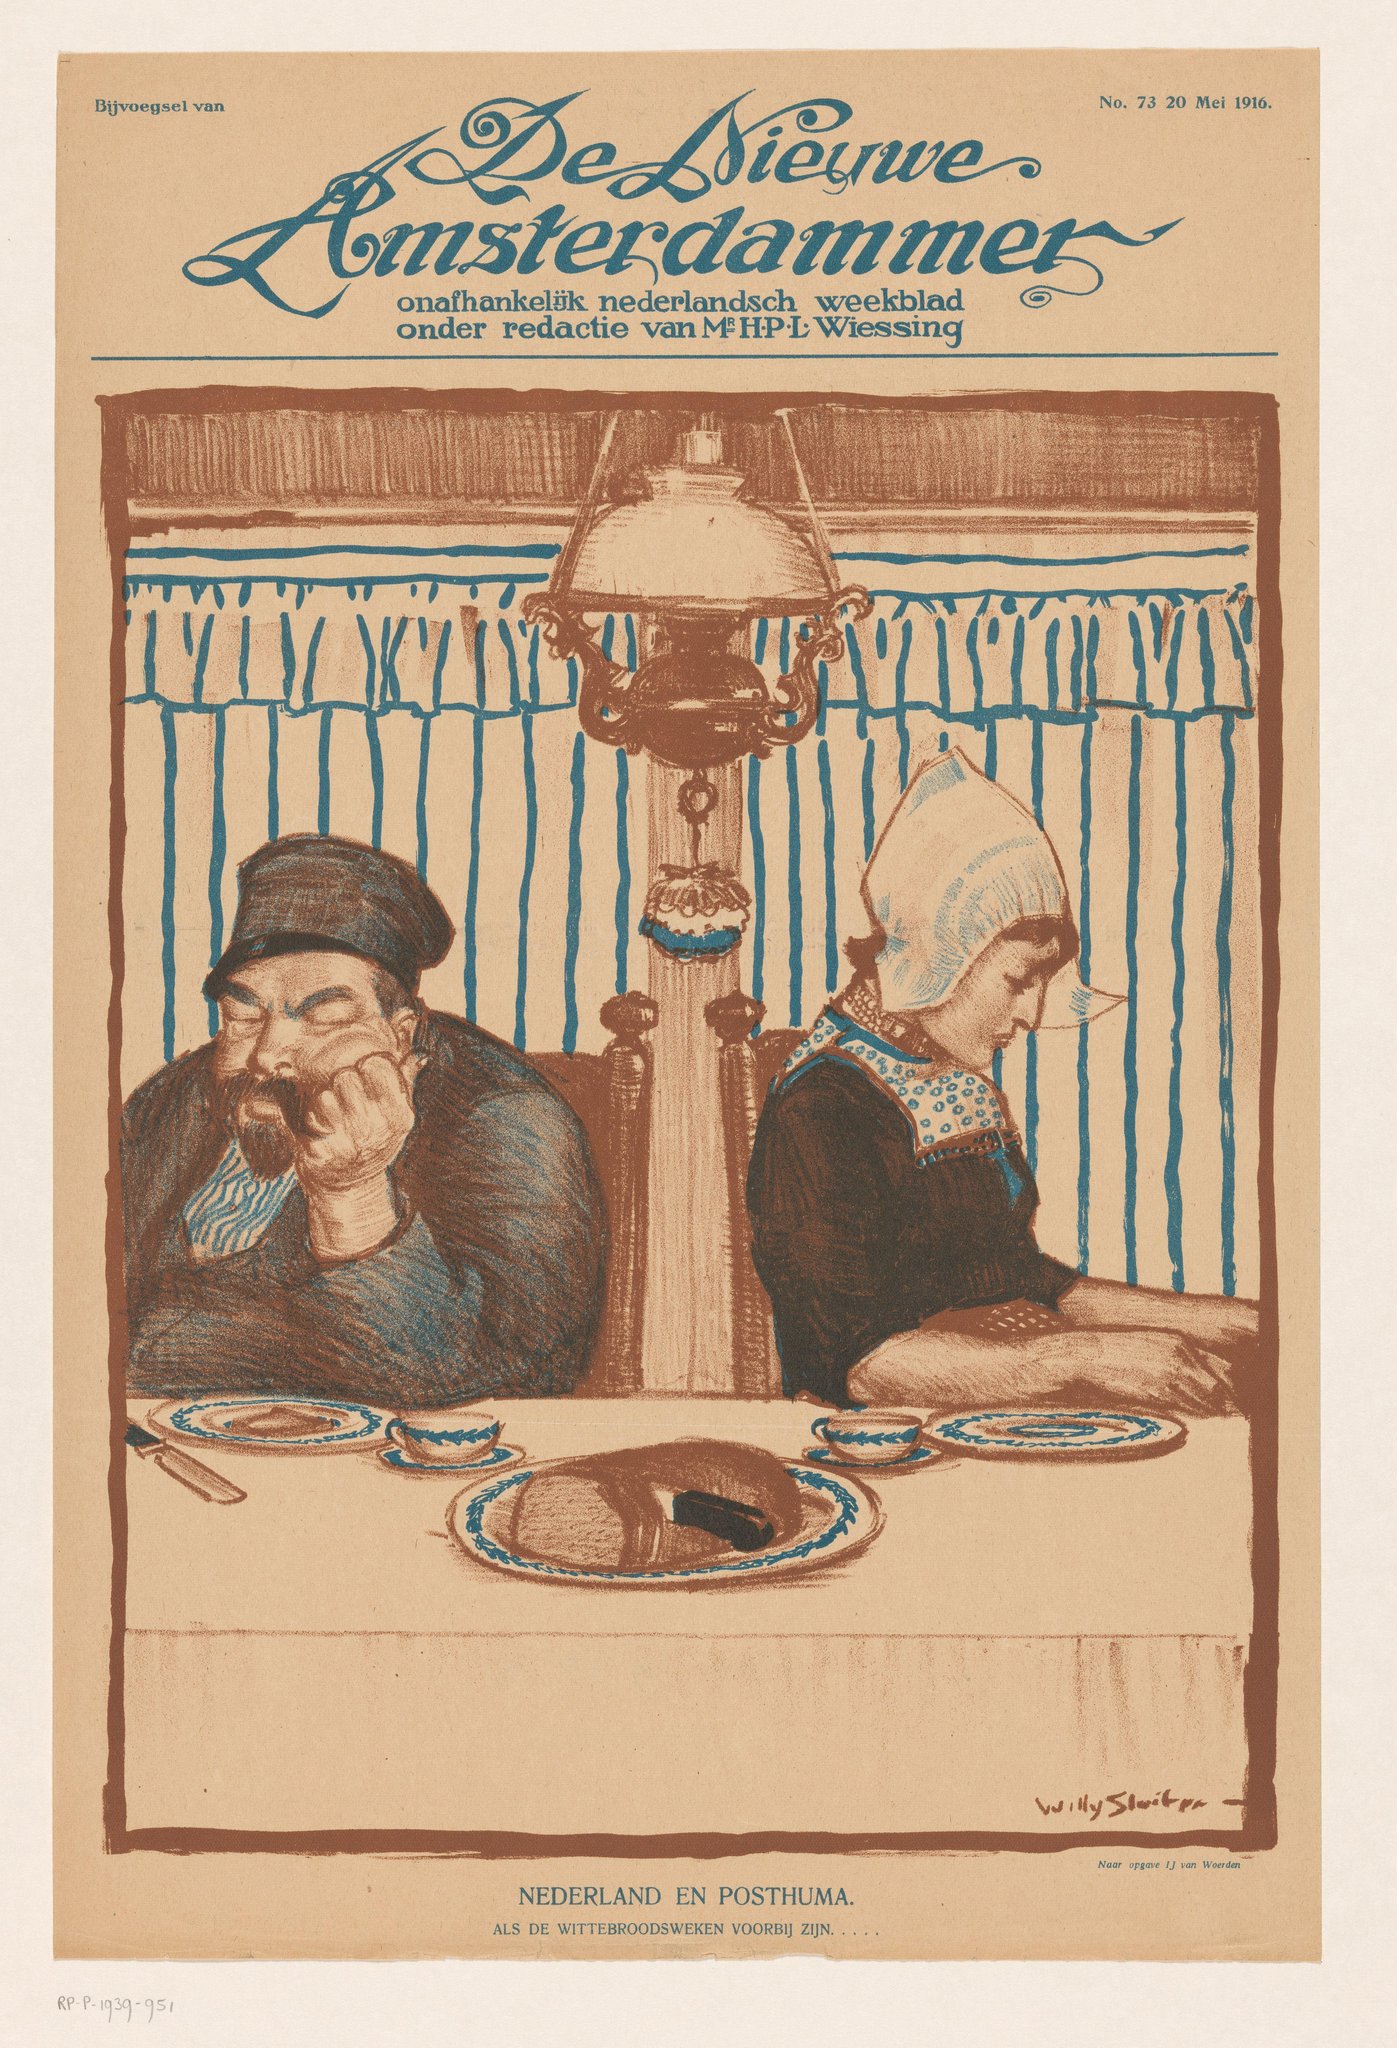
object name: print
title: Nederland en Posthuma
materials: paper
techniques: letterpress printing, lithograph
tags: politician, food rationing, folk costume, regional costume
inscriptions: collector's mark: Lugt 2760, collector's mark: Lugt 2228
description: Een gedekte tafel met in het midden een brood met een mes erin. Links zit minister Folkert Posthuma met zijn hoofd rustend in zijn hand. Links zit een vrouw in klederdracht met haar rug naar hem toe. Onder de voorstelling het opschrift: 'Als de wittebroodsweken voorbij zijn...'